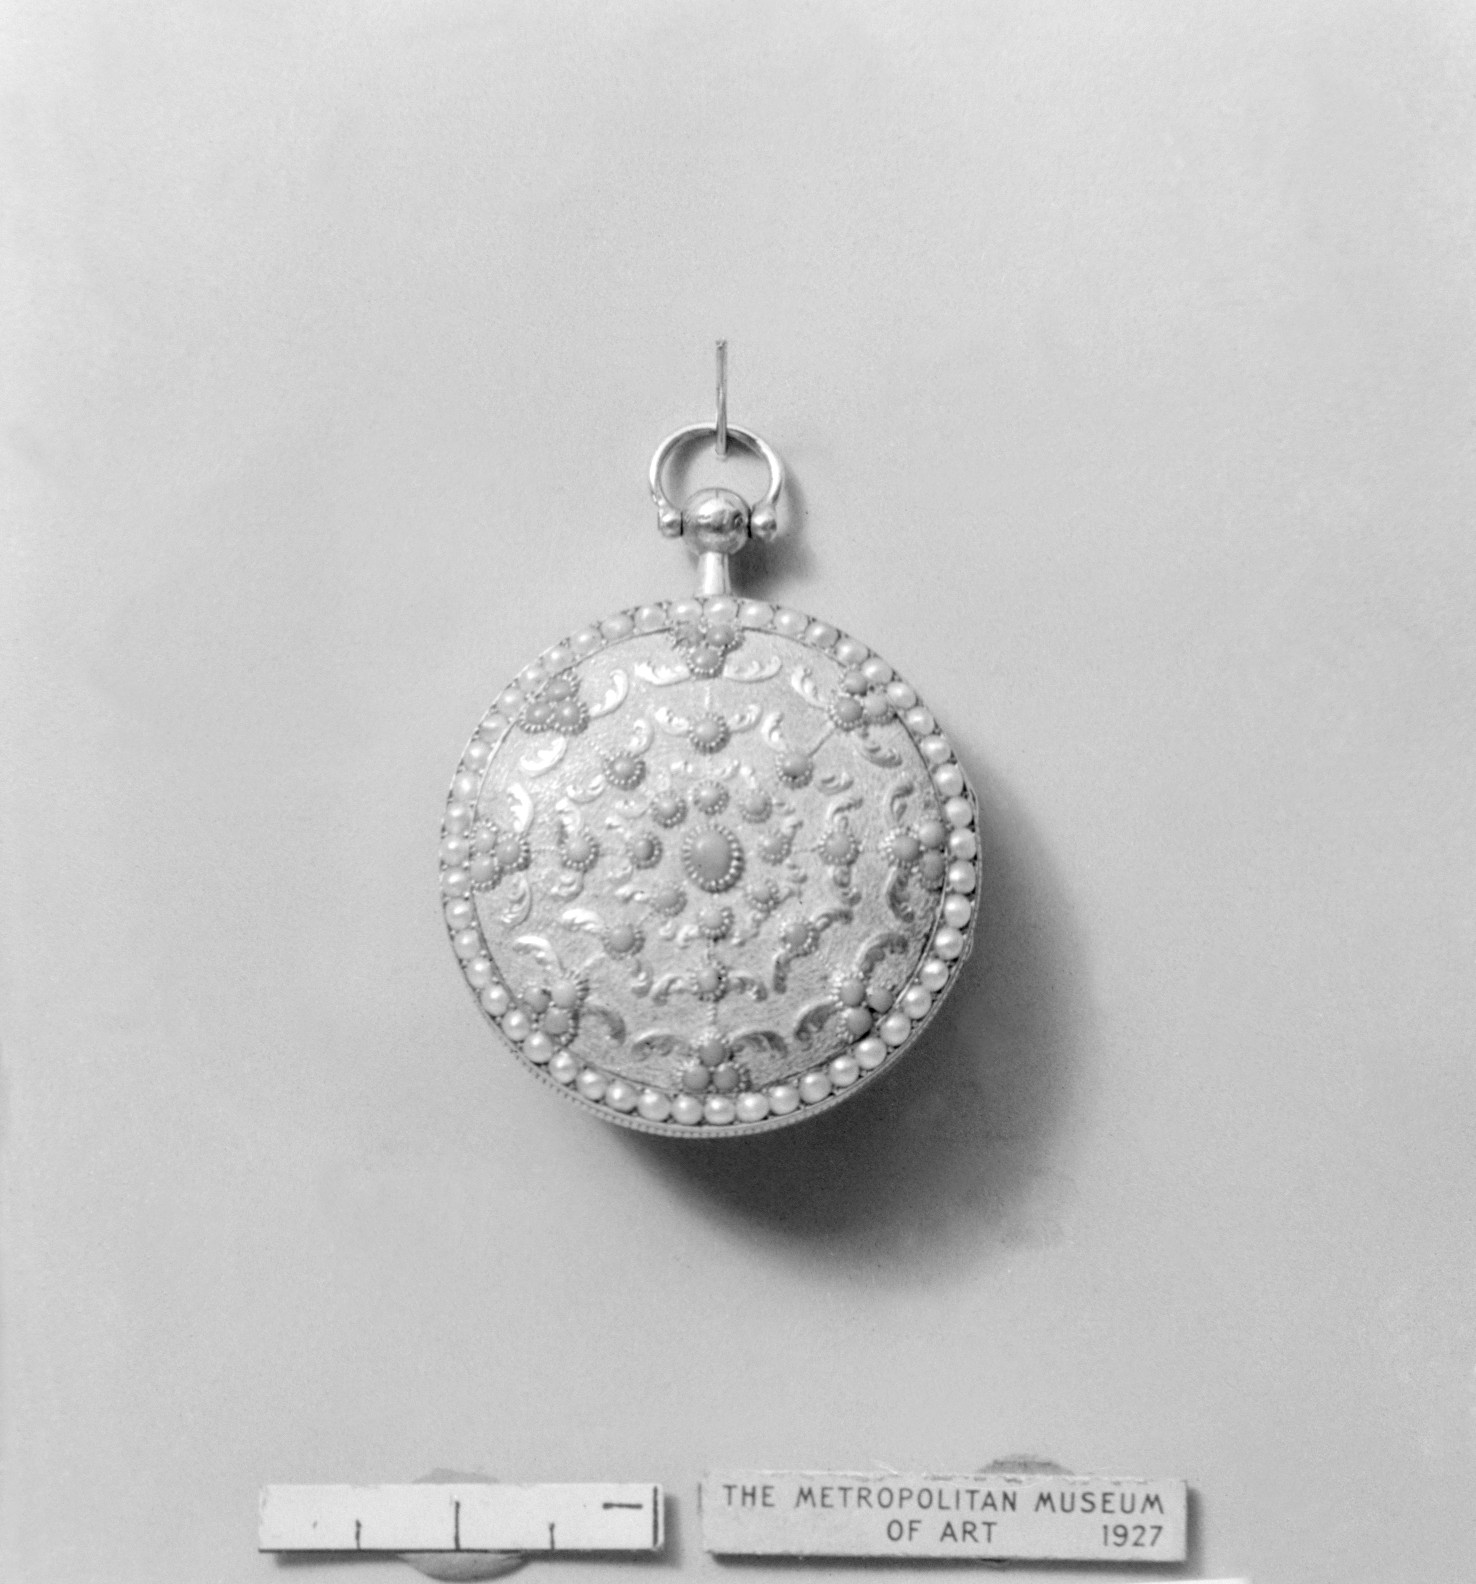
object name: watch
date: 1815-1830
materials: gold, pearl